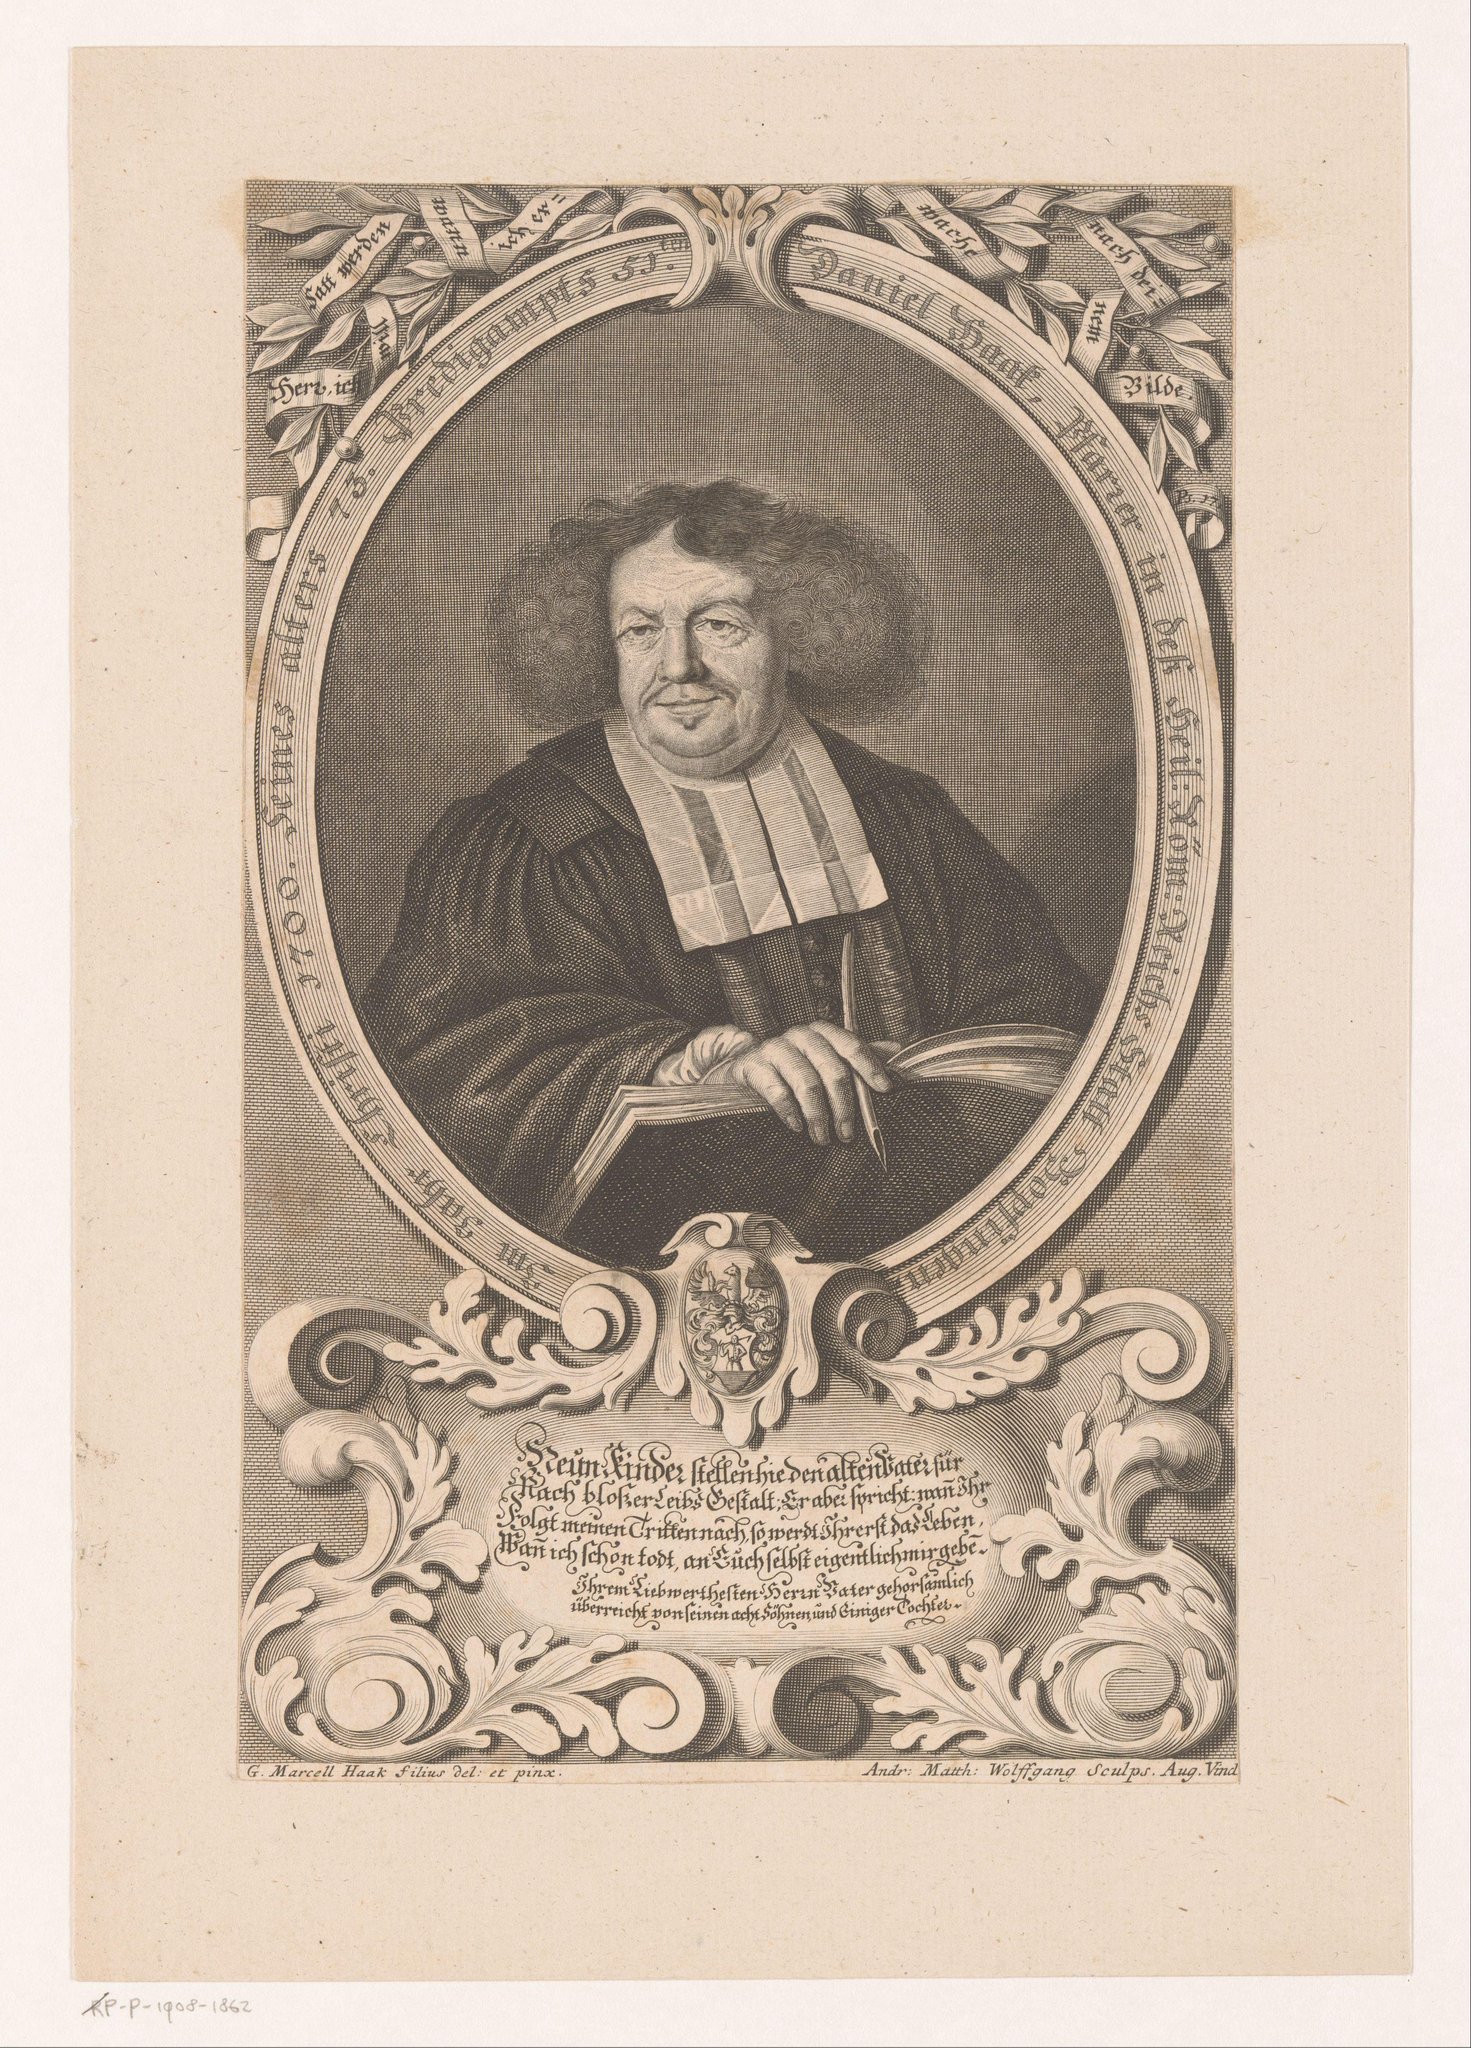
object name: print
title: Portret van Daniel Haak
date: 1670-1737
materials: paper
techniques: engraving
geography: augsburg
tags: daniel haak, historical persons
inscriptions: collector's mark: Lugt 9, collector's mark: Lugt 2228